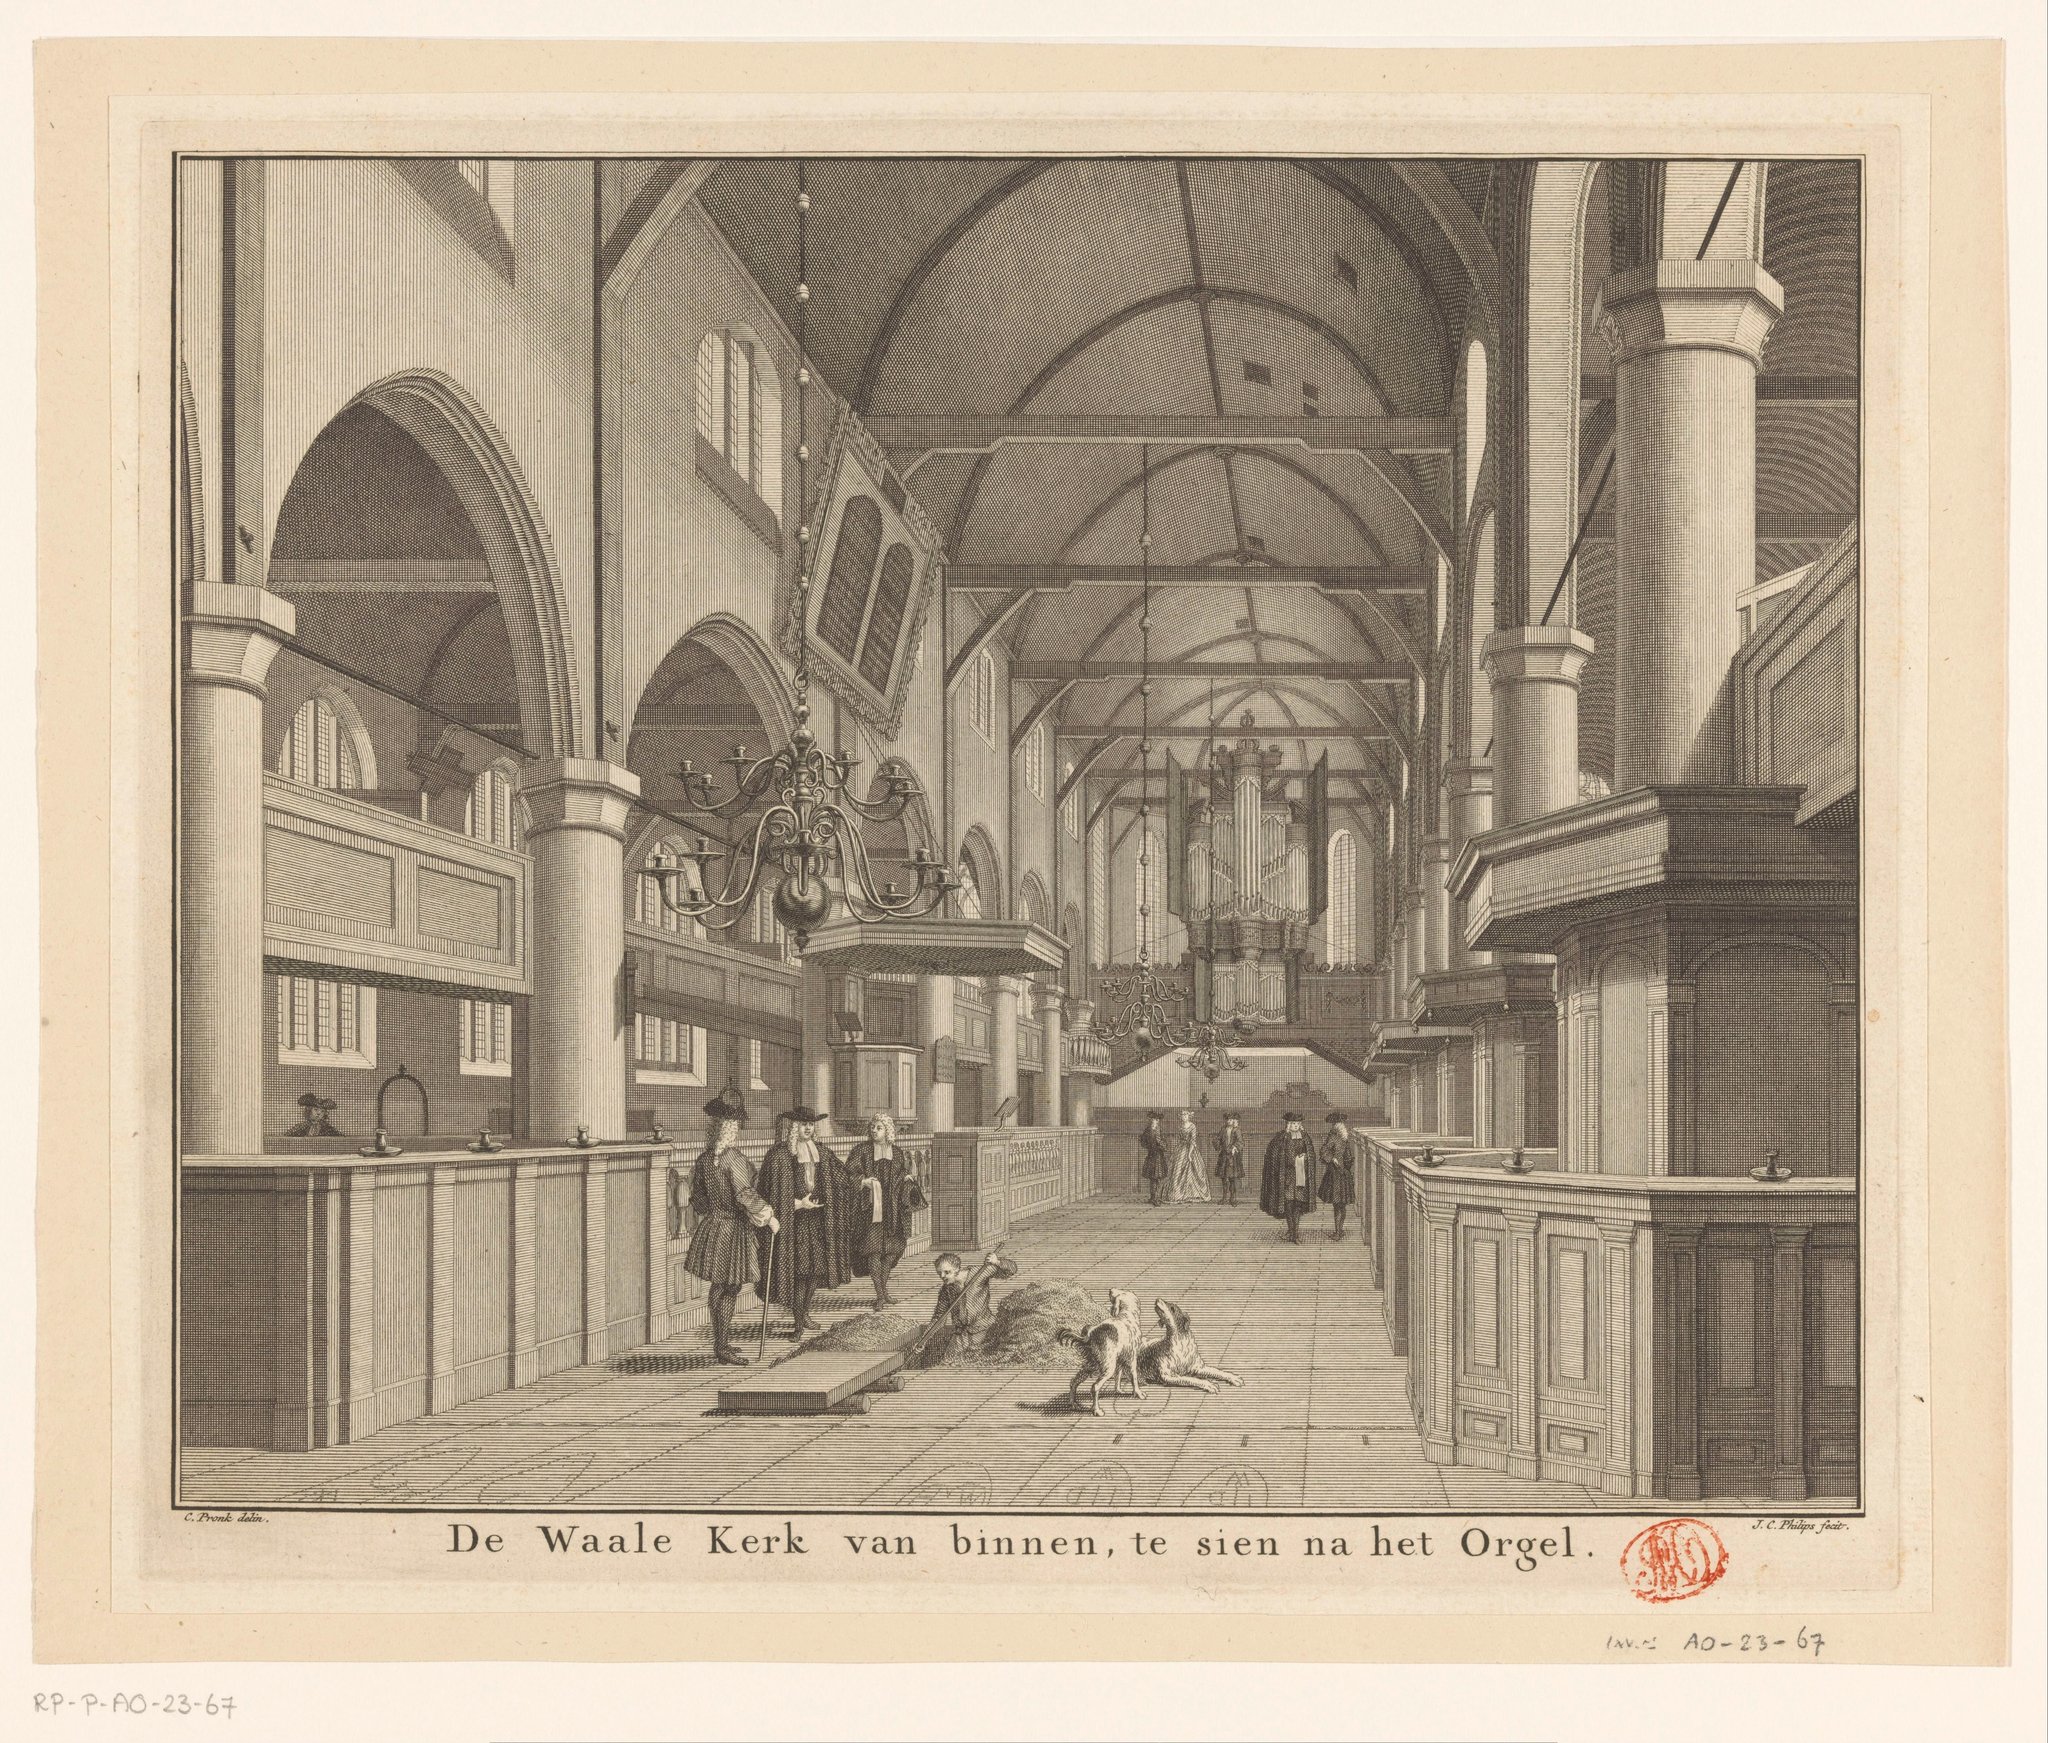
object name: print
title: Interieur van de Waalse Kerk te Amsterdam, gezien richting het orgel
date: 1730-1759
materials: paper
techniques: engraving, etching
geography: amsterdam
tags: church organ, interior of church, grave, tomb and other grave-forms and grave-markers, grave digger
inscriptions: collector's mark: Lugt 195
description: Interieur van de Waalse Kerk te Amsterdam, gezien richting het orgel. In de kerk verschillende figuren. Op de voorgrond wordt een graf gedolven.